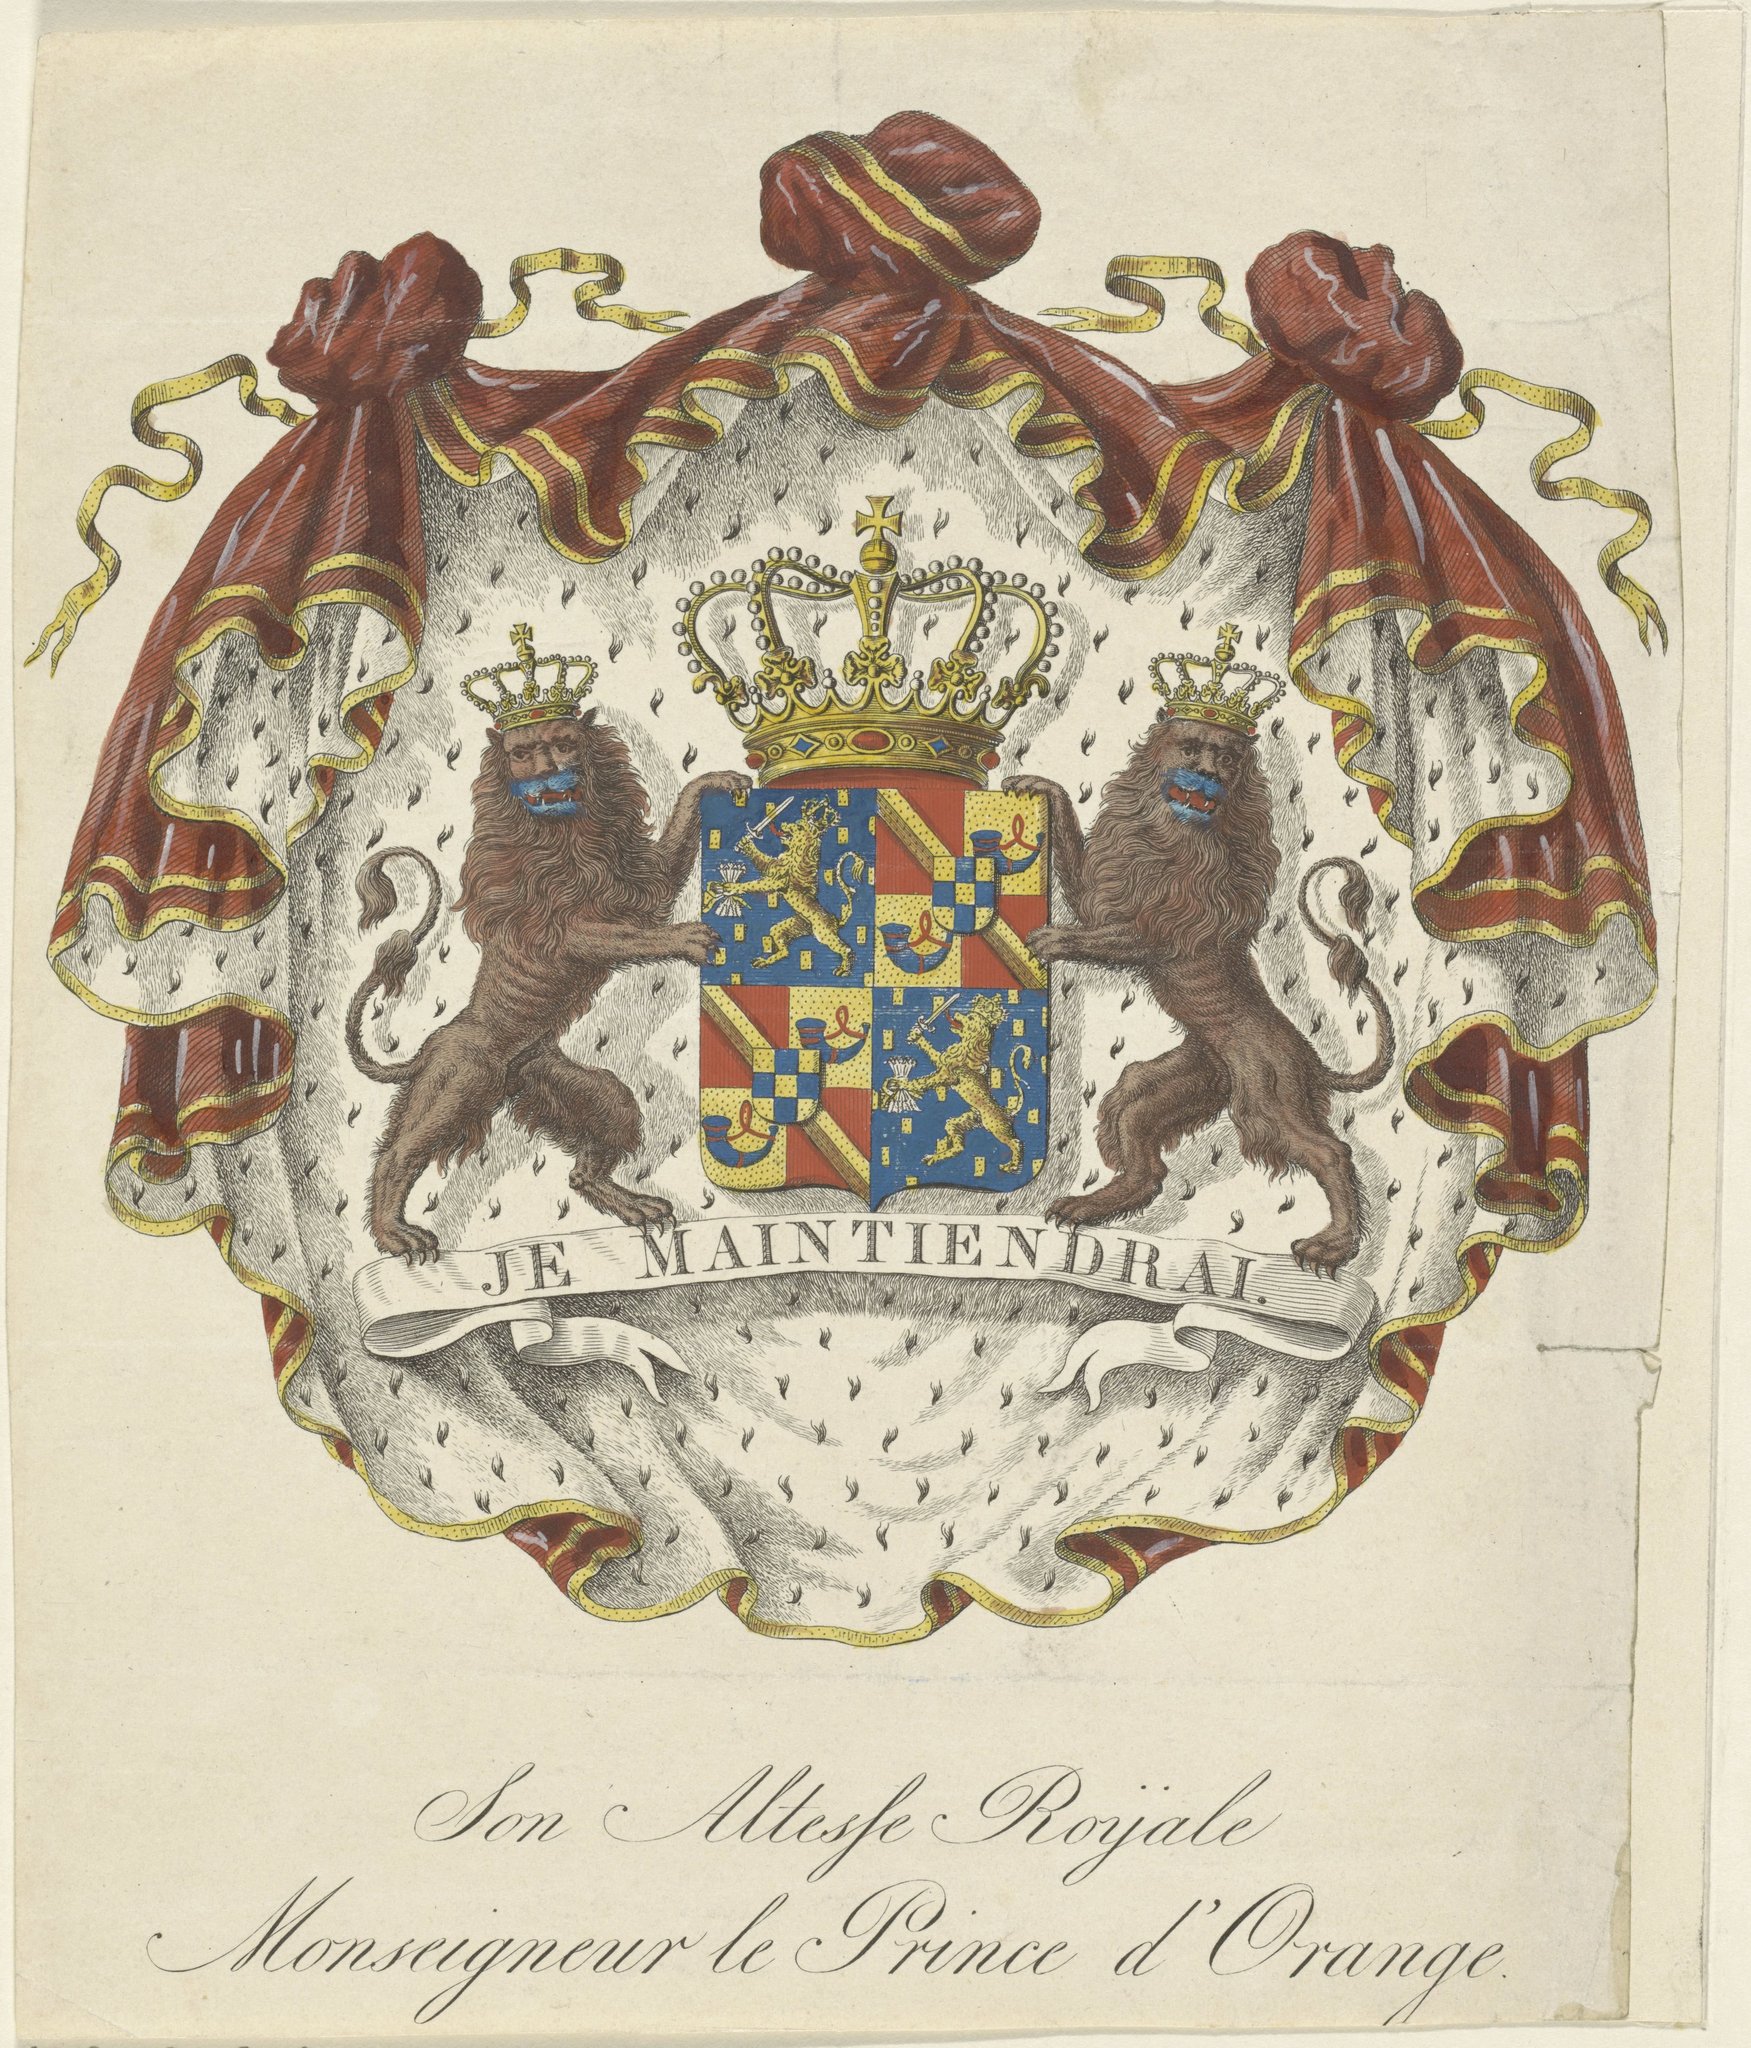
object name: print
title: Wapen van Willem III, koning der Nederlanden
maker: Anonymous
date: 1817-1899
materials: paper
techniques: engraving, etching, hand coloring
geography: netherlands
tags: brussels, willem iii (koning der nederlanden)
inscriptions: collector's mark: Lugt 2233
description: Wapen van Willem III met een kroon en twee leeuwen. Daaronder op een banderol zijn geslachtsspreuk. Daar omheen een hermelijnen mantel. In de ondermarge twee regels Franse tekst.